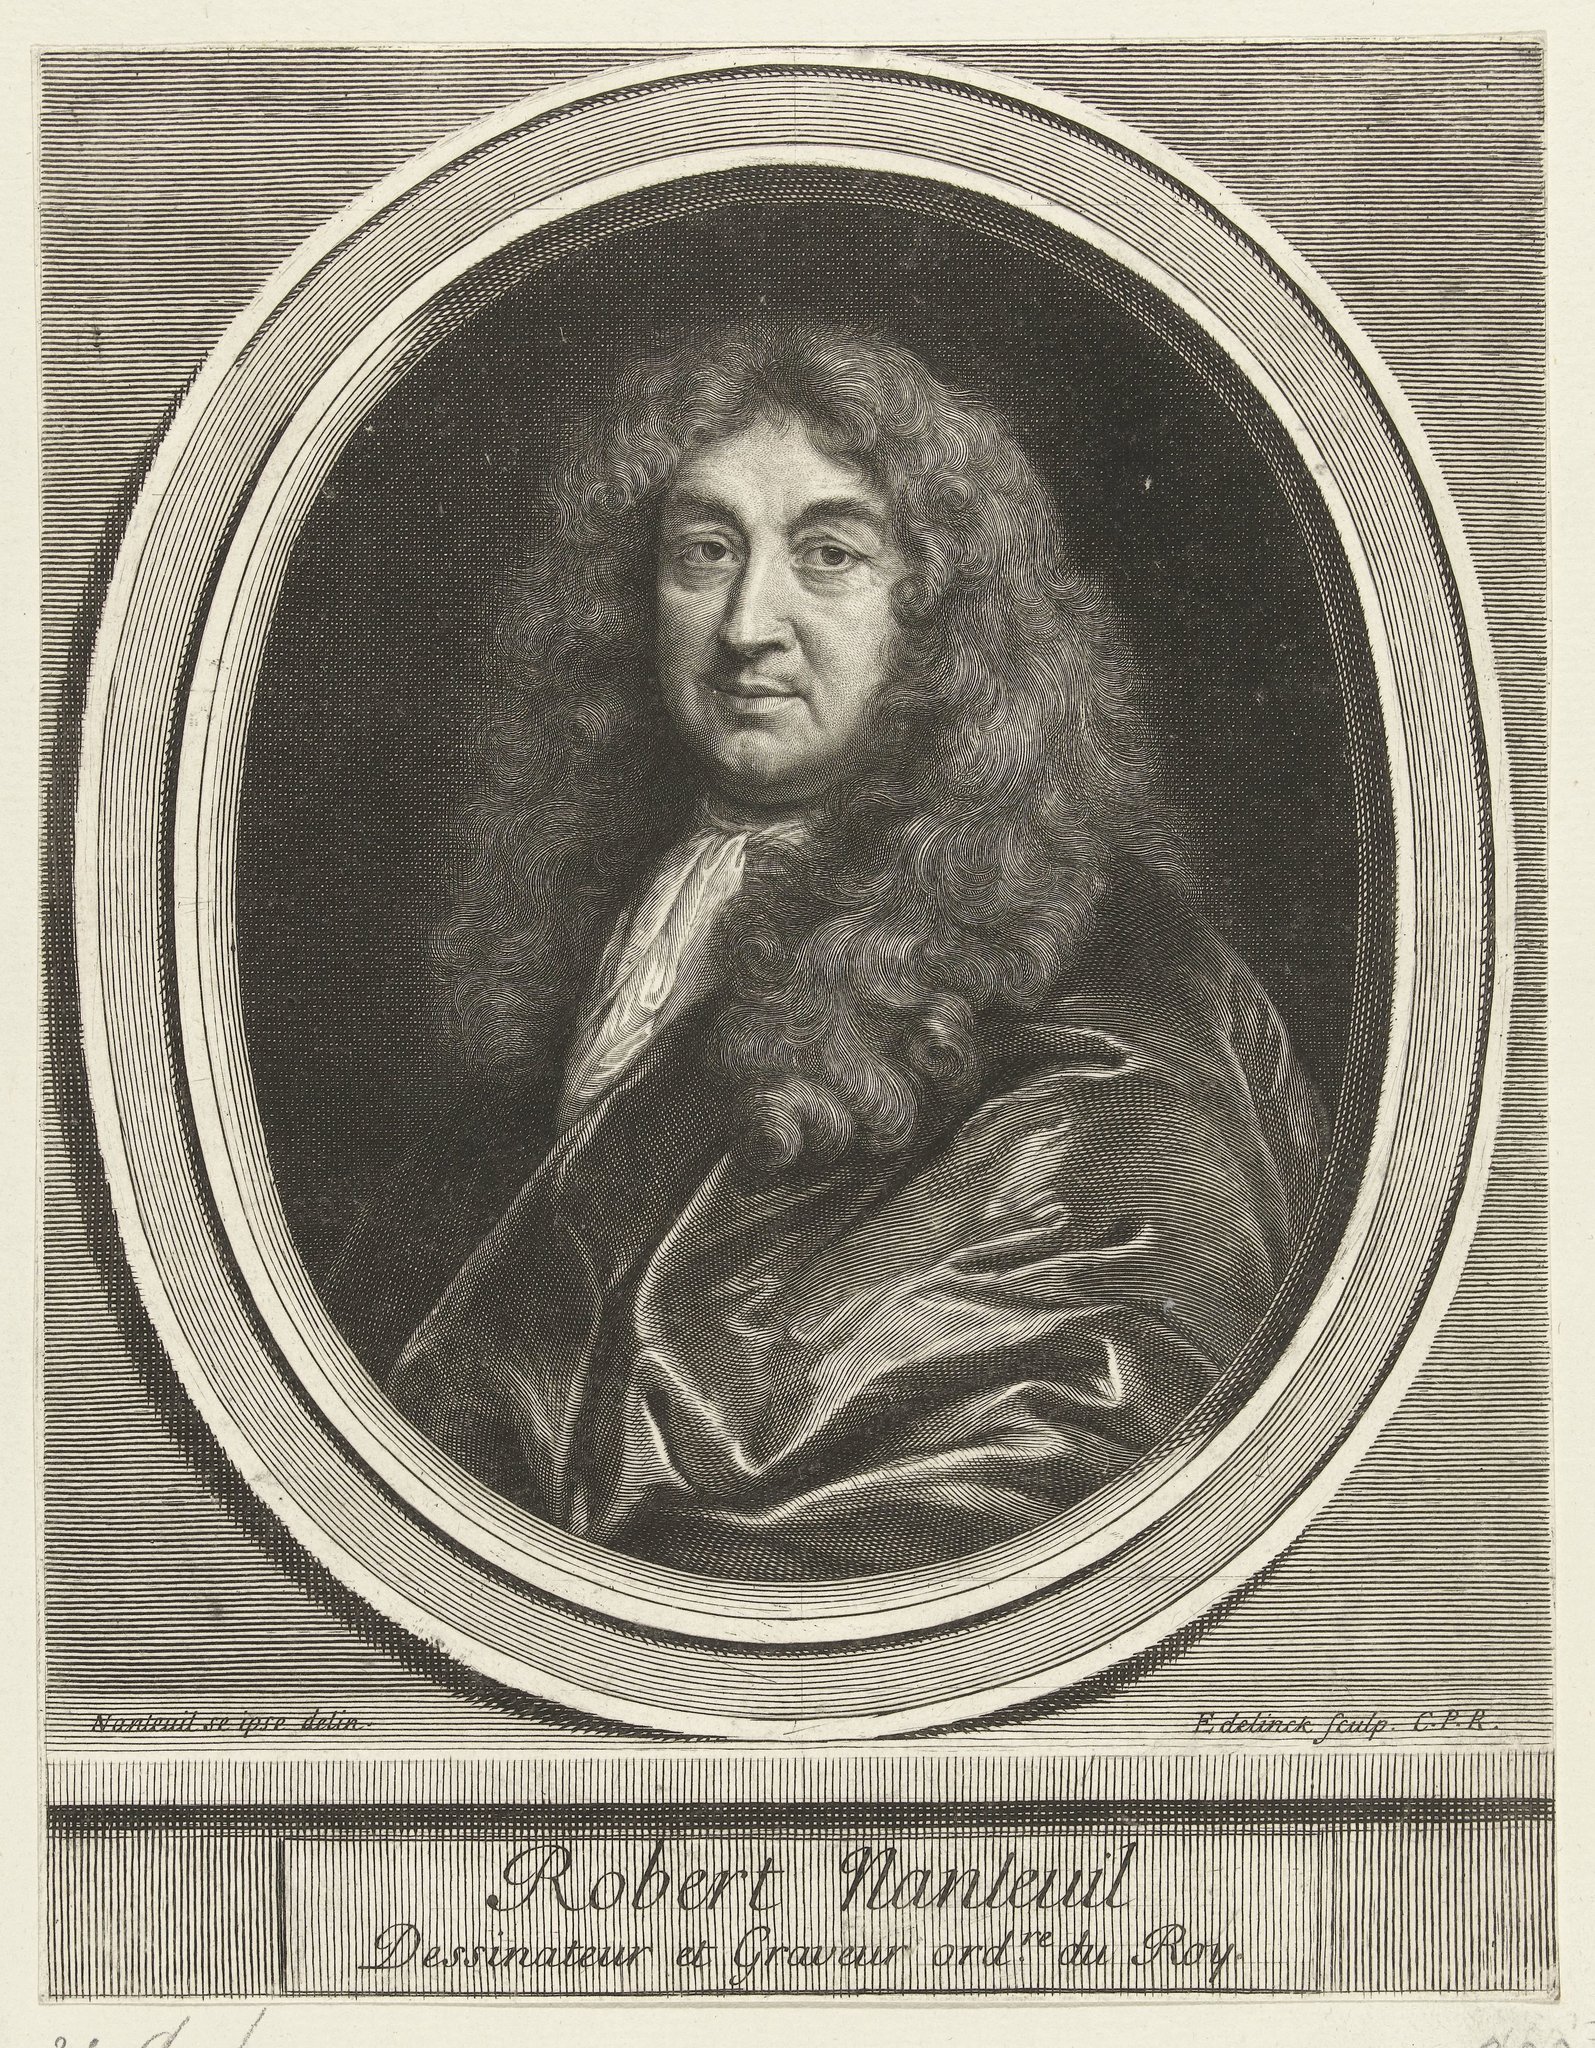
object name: print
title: Portret van Robert Nanteuil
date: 1666-1707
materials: paper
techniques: engraving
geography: france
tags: paris, print maker, robert nanteuil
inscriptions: collector's mark: Lugt 240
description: Portret van de Franse hofkunstenaar Robert Nanteuil (1623-1678), ten halven lijve afgebeeld in ovale omlijsting.